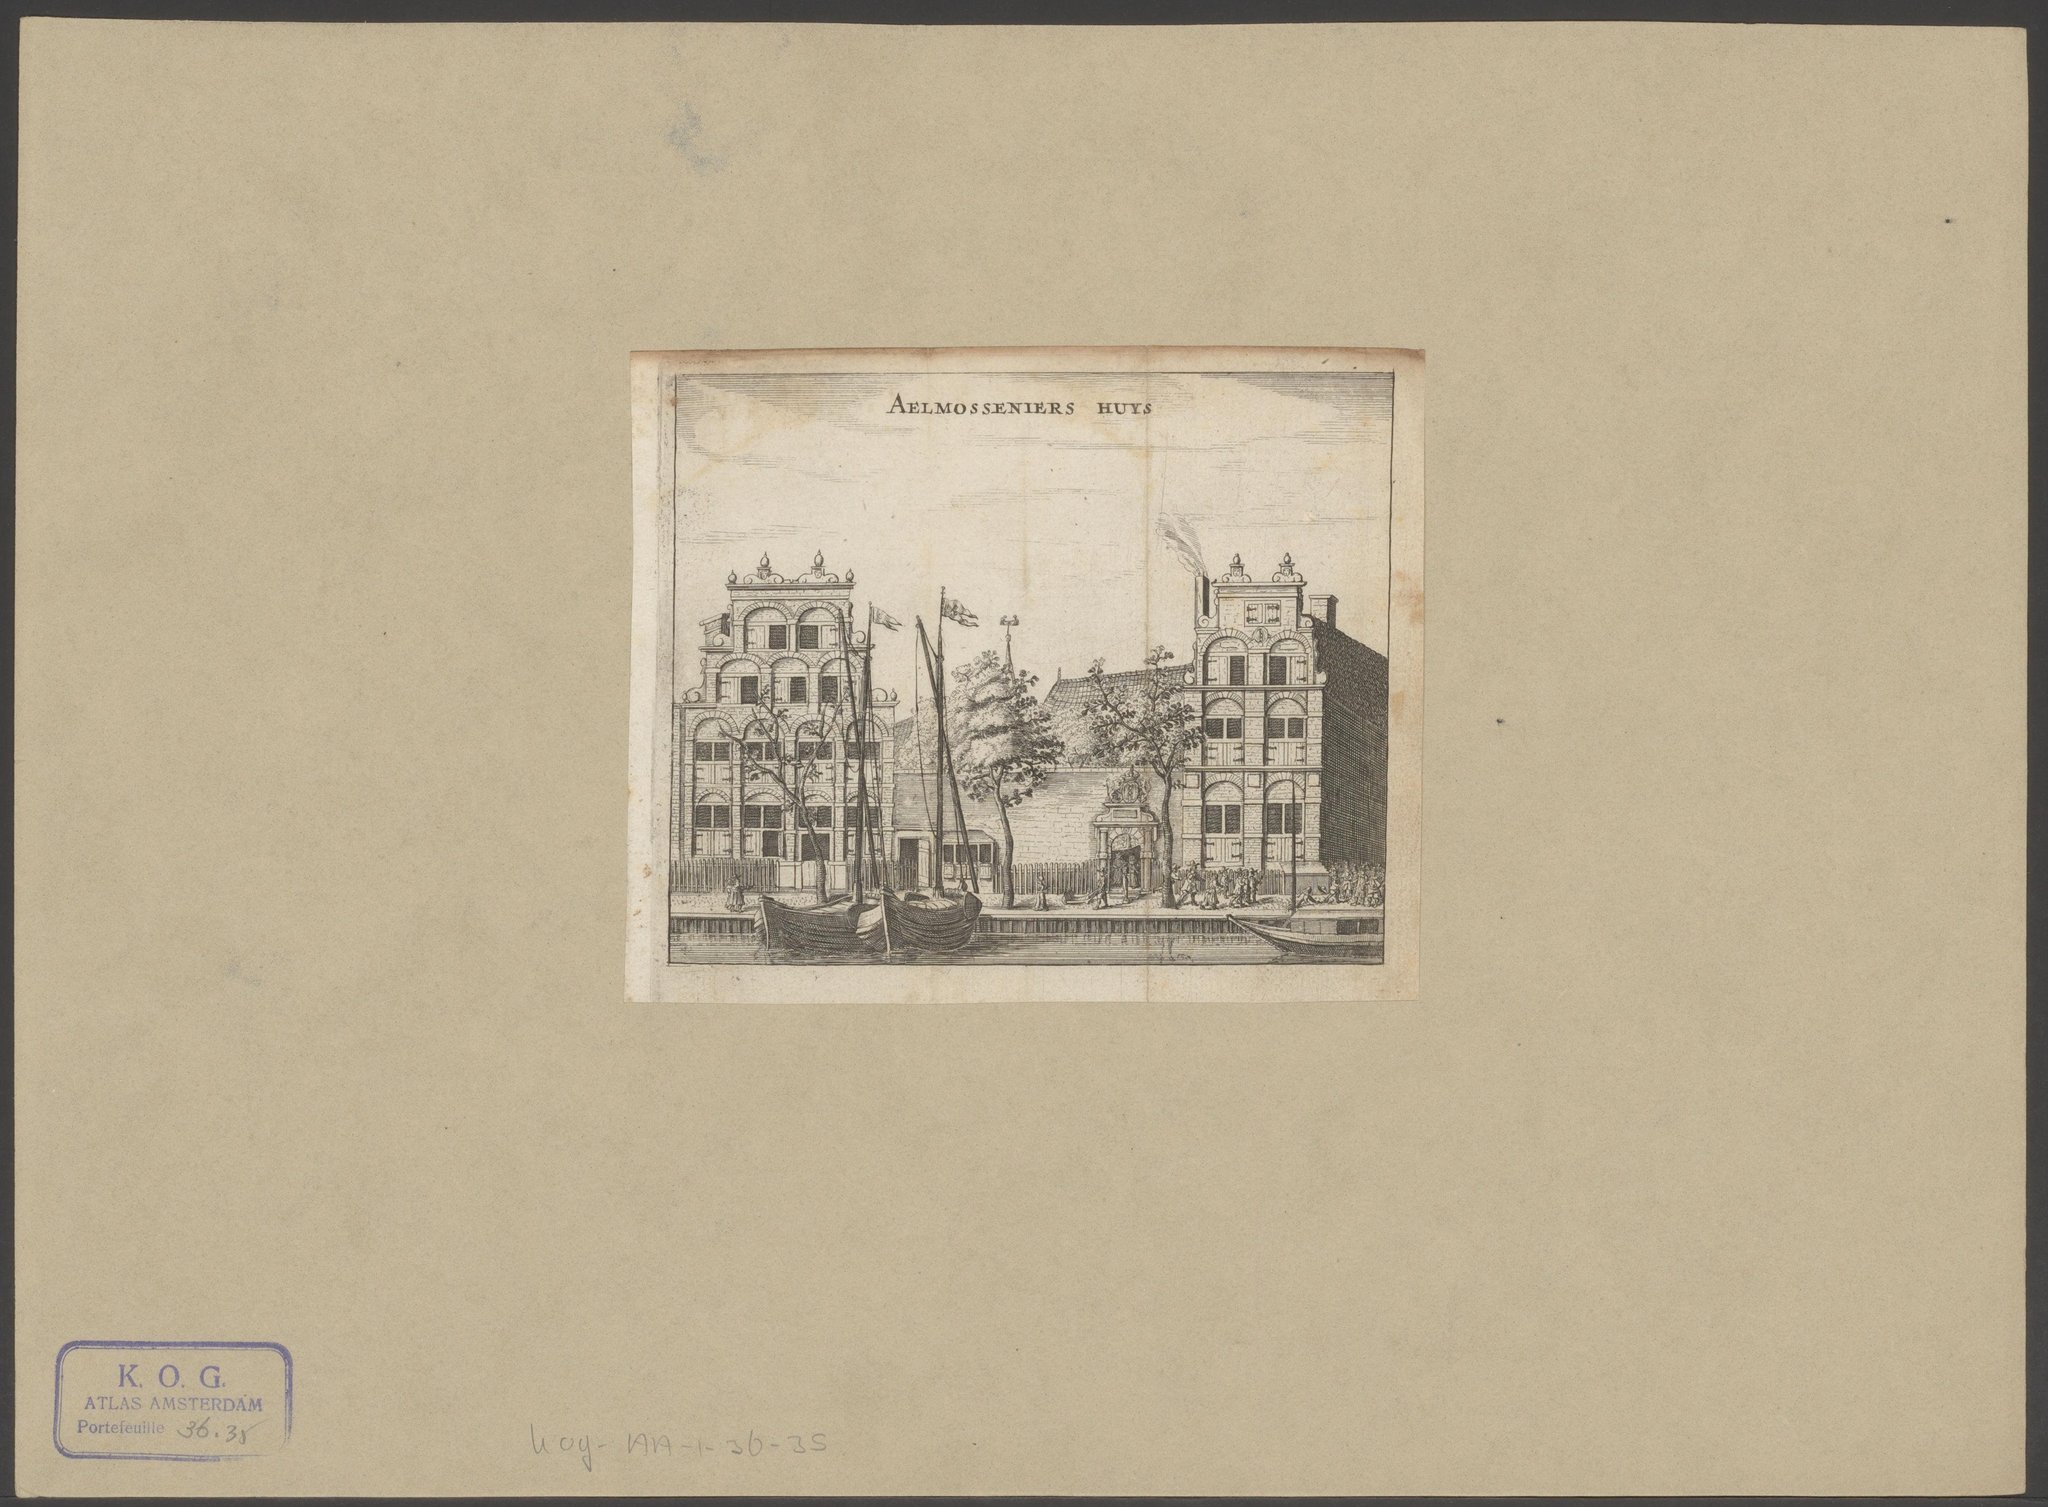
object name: book illustration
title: Gezicht op het Aalmoezeniershuis te Amsterdam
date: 1664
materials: paper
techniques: engraving, etching, letterpress printing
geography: amsterdam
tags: public welfare, poorhouse, canal, orphanage, street (+ city(-scape) with figures, staffage), amsterdam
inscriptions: collector's mark: Lugt 1641b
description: Huidige staat van prent ook gebruikt in: Fockens, Melchior. Beschrijving Der wijdt-vermaarde Koop-stadt Amstelredam, Van haar eerste beginselen, zedert den Jare 1203. oude Voorrechten, verscheyde Vergrootingenoude Voor-rechten, en verscheyde Vergrootingen (…). 3de druk. Amsterdam: Marcus Willemsz. Doornick, 1664. En in: Zesen, Philipp von. Beschrybung der Weidtberuhmde Kauf-Stadt Amstelredam / Beschreibung der Stadt Amsterdam darinnen von derselben ersten ursprunge bis auf gegenwartigen zustand (…). Amsterdam: Marcus Willemsz. Doornick, 1664. Tweede bekende staat (met toevoeging Franse titel) ook gebruikt in: Domselaer, Tobias en Isaac Commelin. Beschryvinge van Amsterdam : haar eerste oorspronk uyt den huyze der heeren van Aemstel en Aemstellant (…). 6 dln. Amsterdam: Marcus Willemsz van Doornick, 1665. In tegenstelling tot meeste prenten uit bovenstaande publicaties is deze prent niet aangepast naar een derde staat en niet gebruikt in verschillende latere zeventiende- en achttiende-eeuwse publicaties.